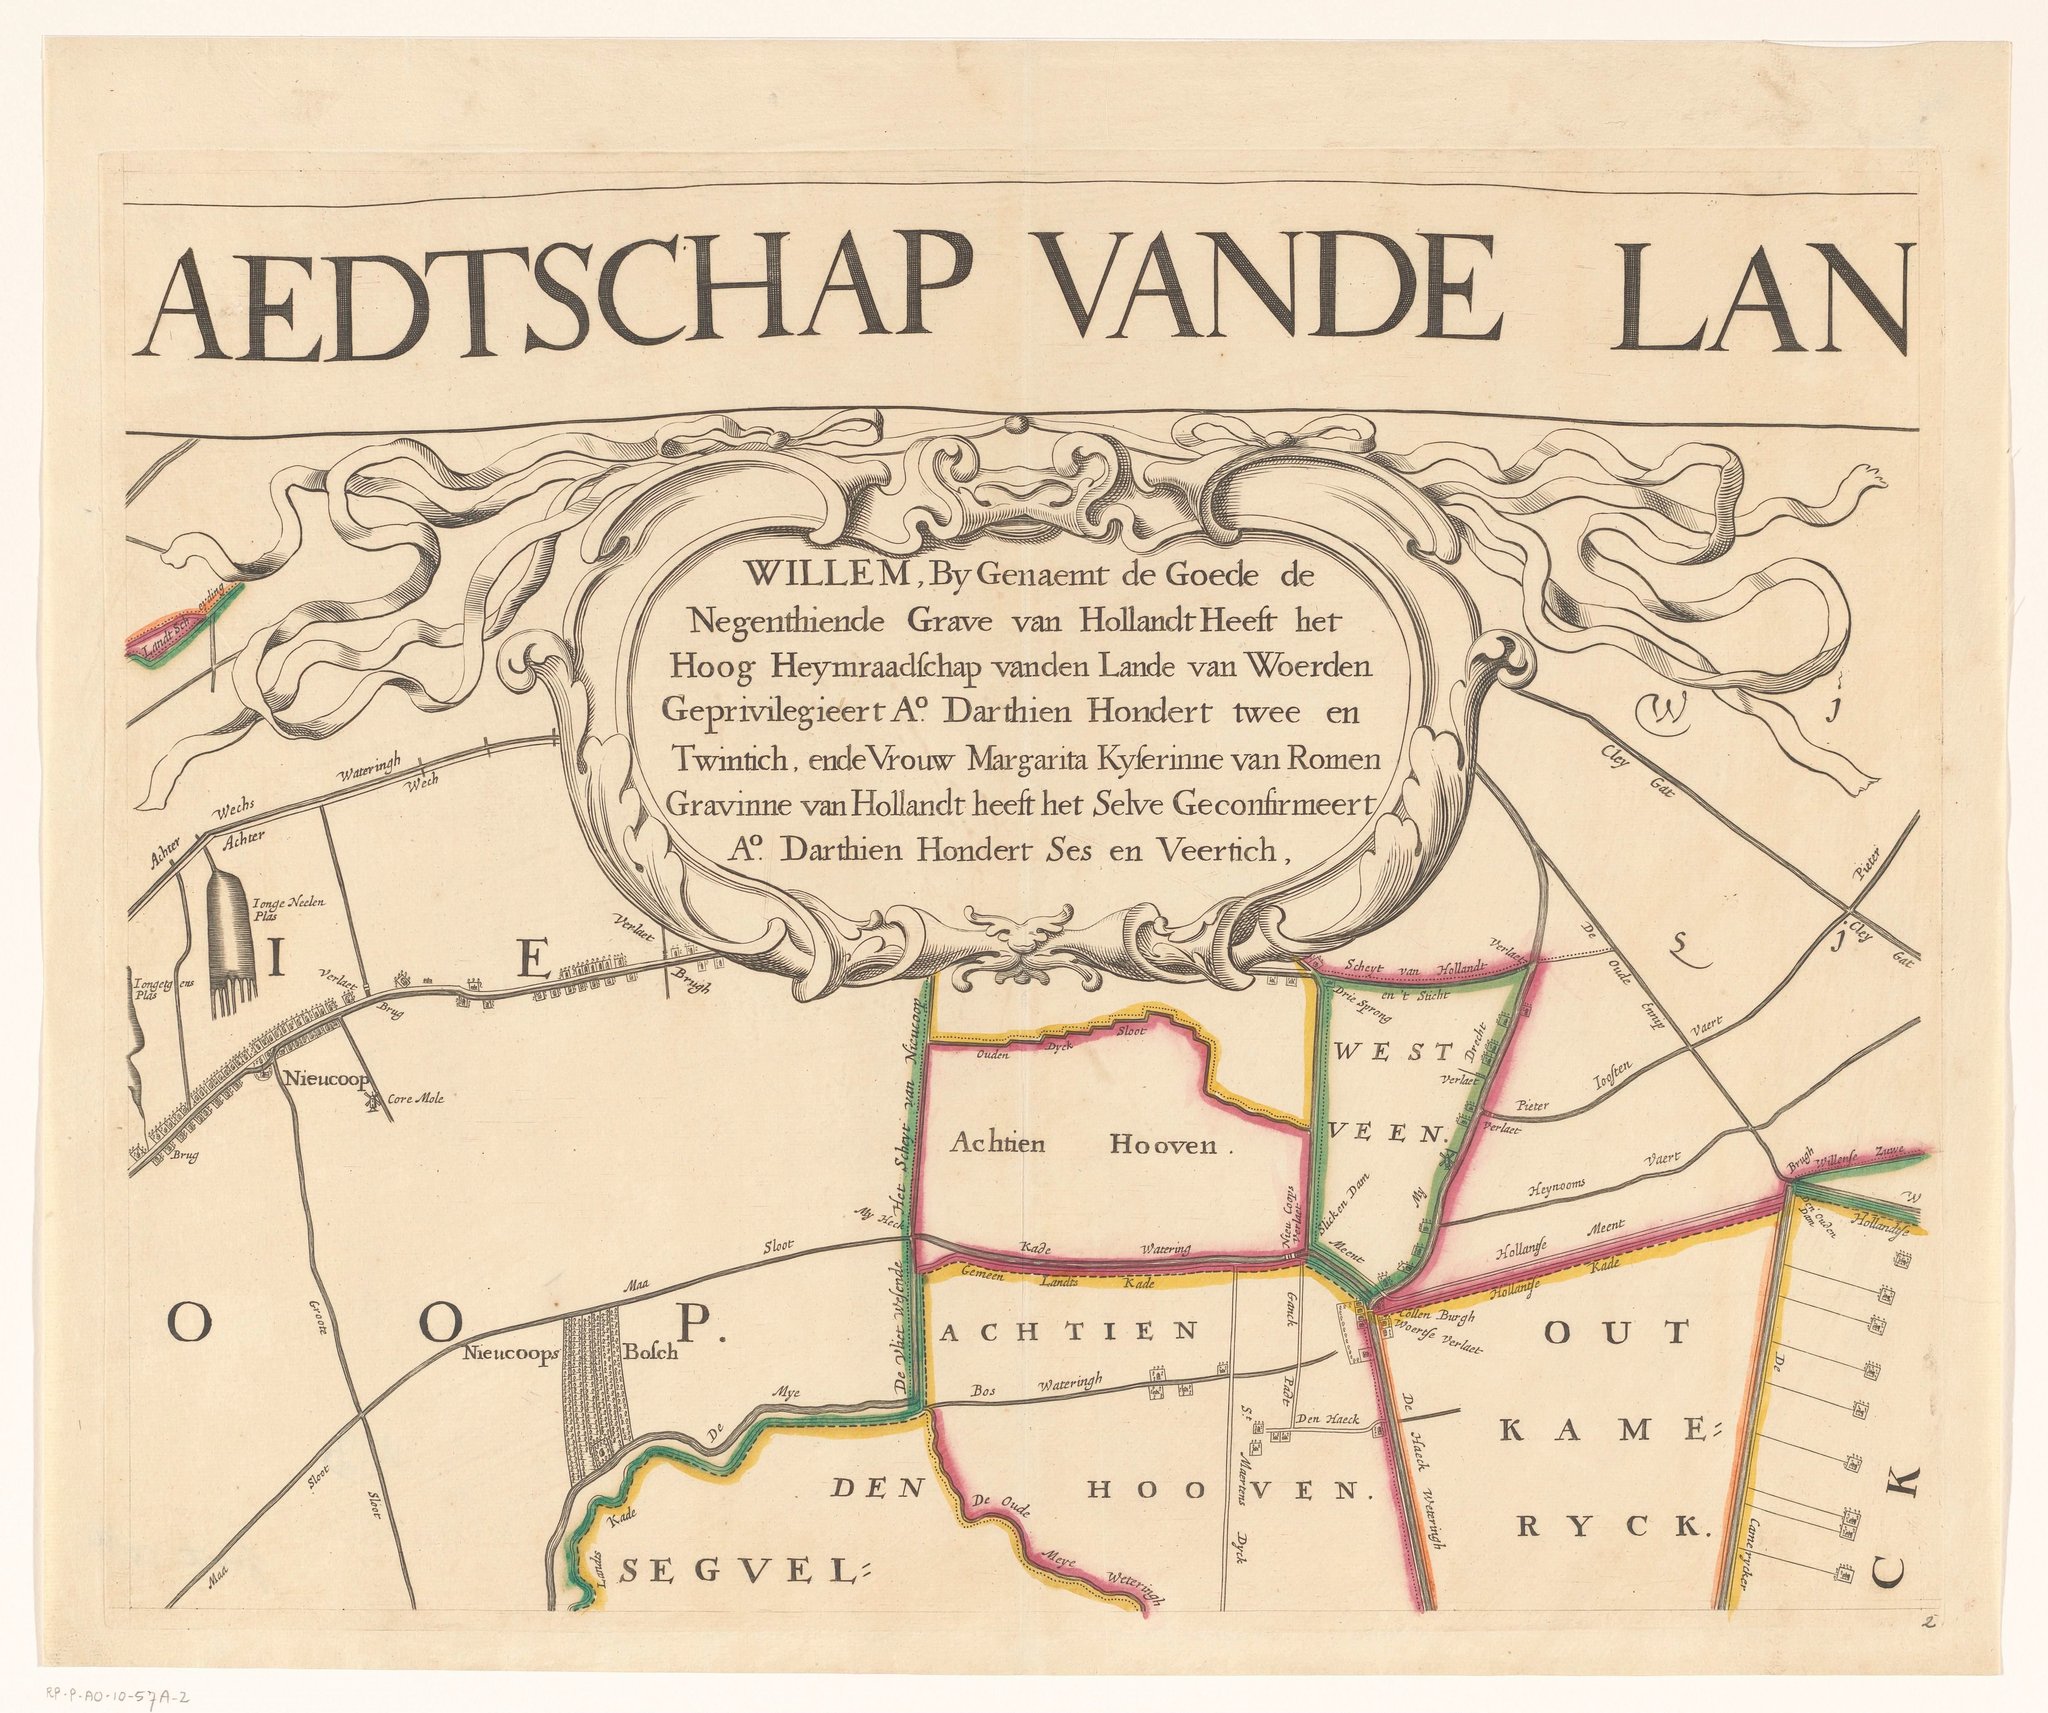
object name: map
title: 't Hooghe Heymraedtschap vande lande van Woerden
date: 1670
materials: paper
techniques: engraving, hand coloring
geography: amsterdam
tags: maps of separate countries or regions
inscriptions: collector's mark: Lugt 2228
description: Tweede deel (boven midden) van een kaart van het Hoogheemraadschap van Woerden.